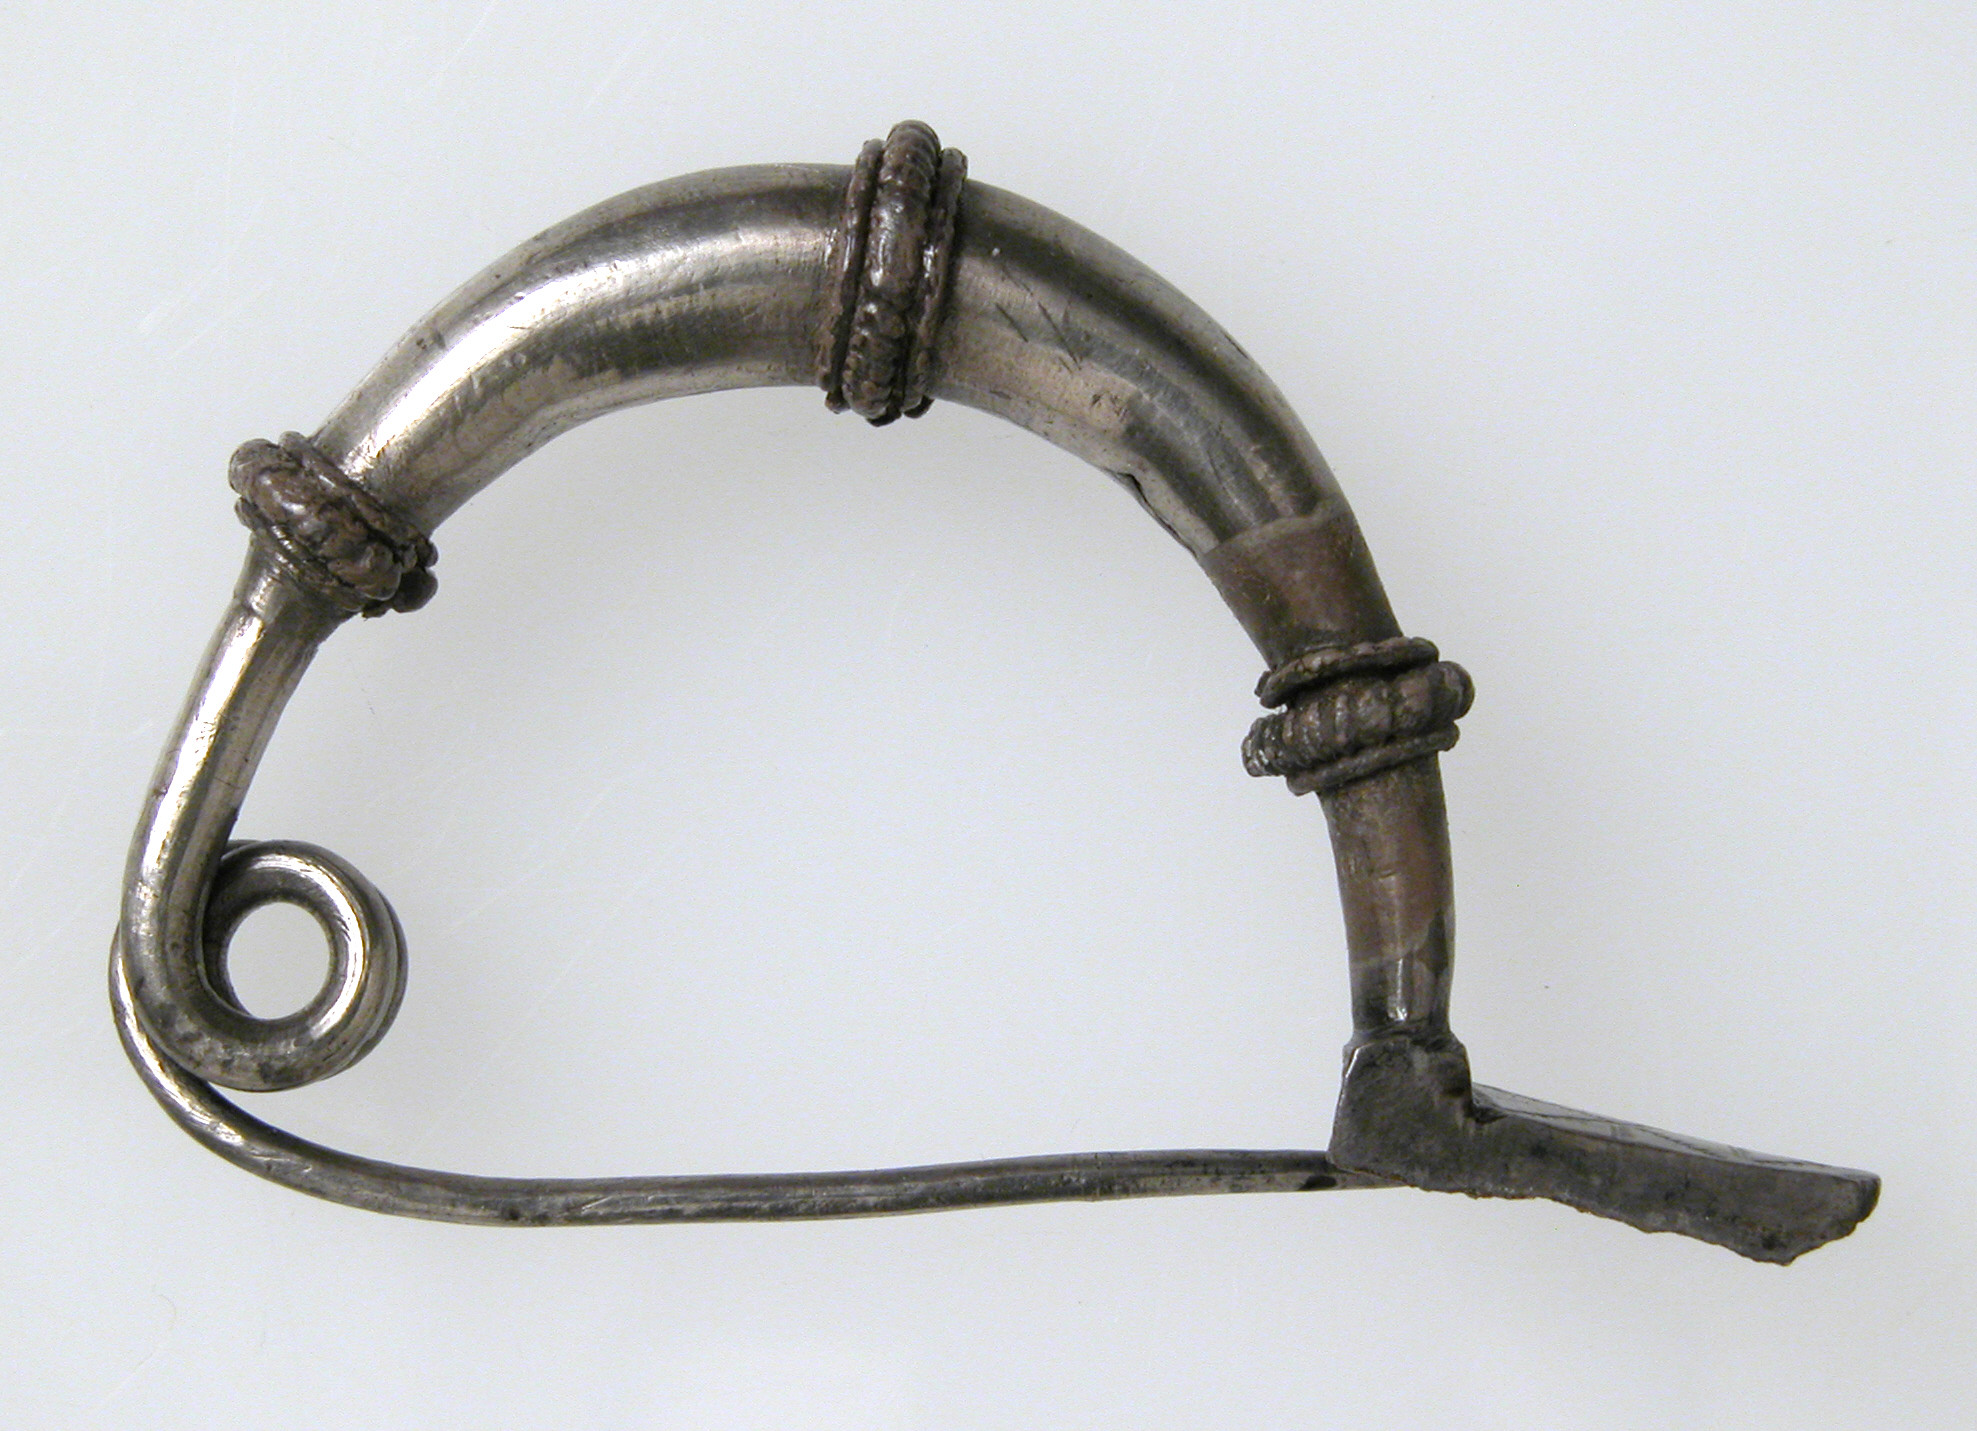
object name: brooch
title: Bow-Shaped Brooch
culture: celtic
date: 500-401 BCE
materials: copper alloy, silver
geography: northern france